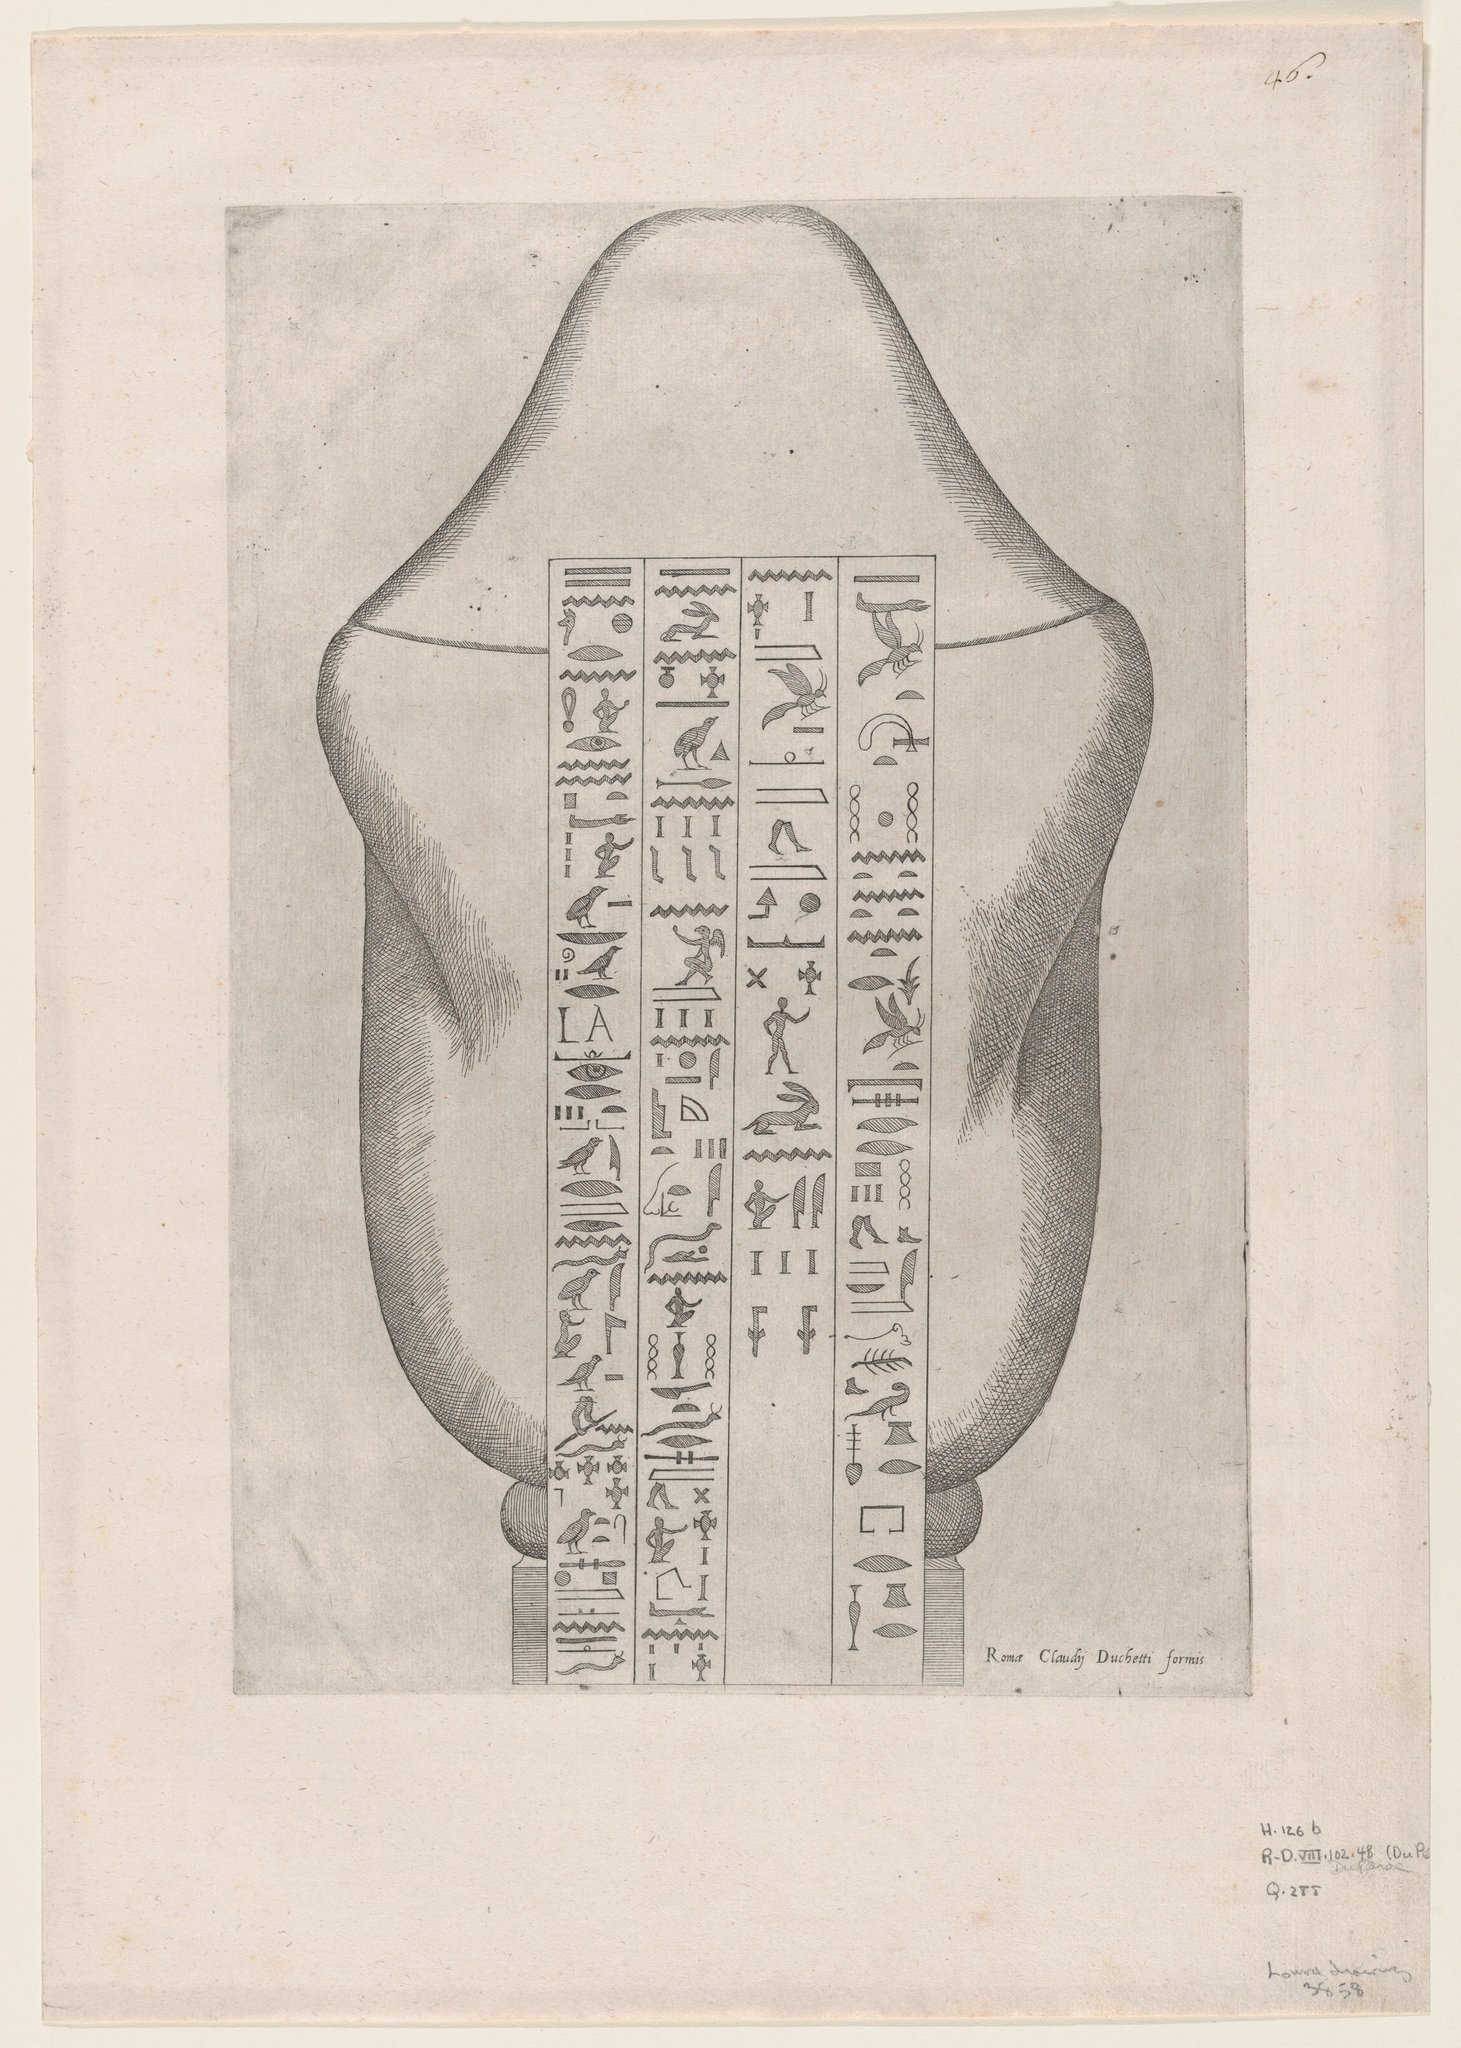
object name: print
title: Back of an Egyptian canopic vase, from "Speculum Romanae Magnificentiae"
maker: etienne dupérac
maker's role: artist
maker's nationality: french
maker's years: 1535-1604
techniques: etching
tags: vases